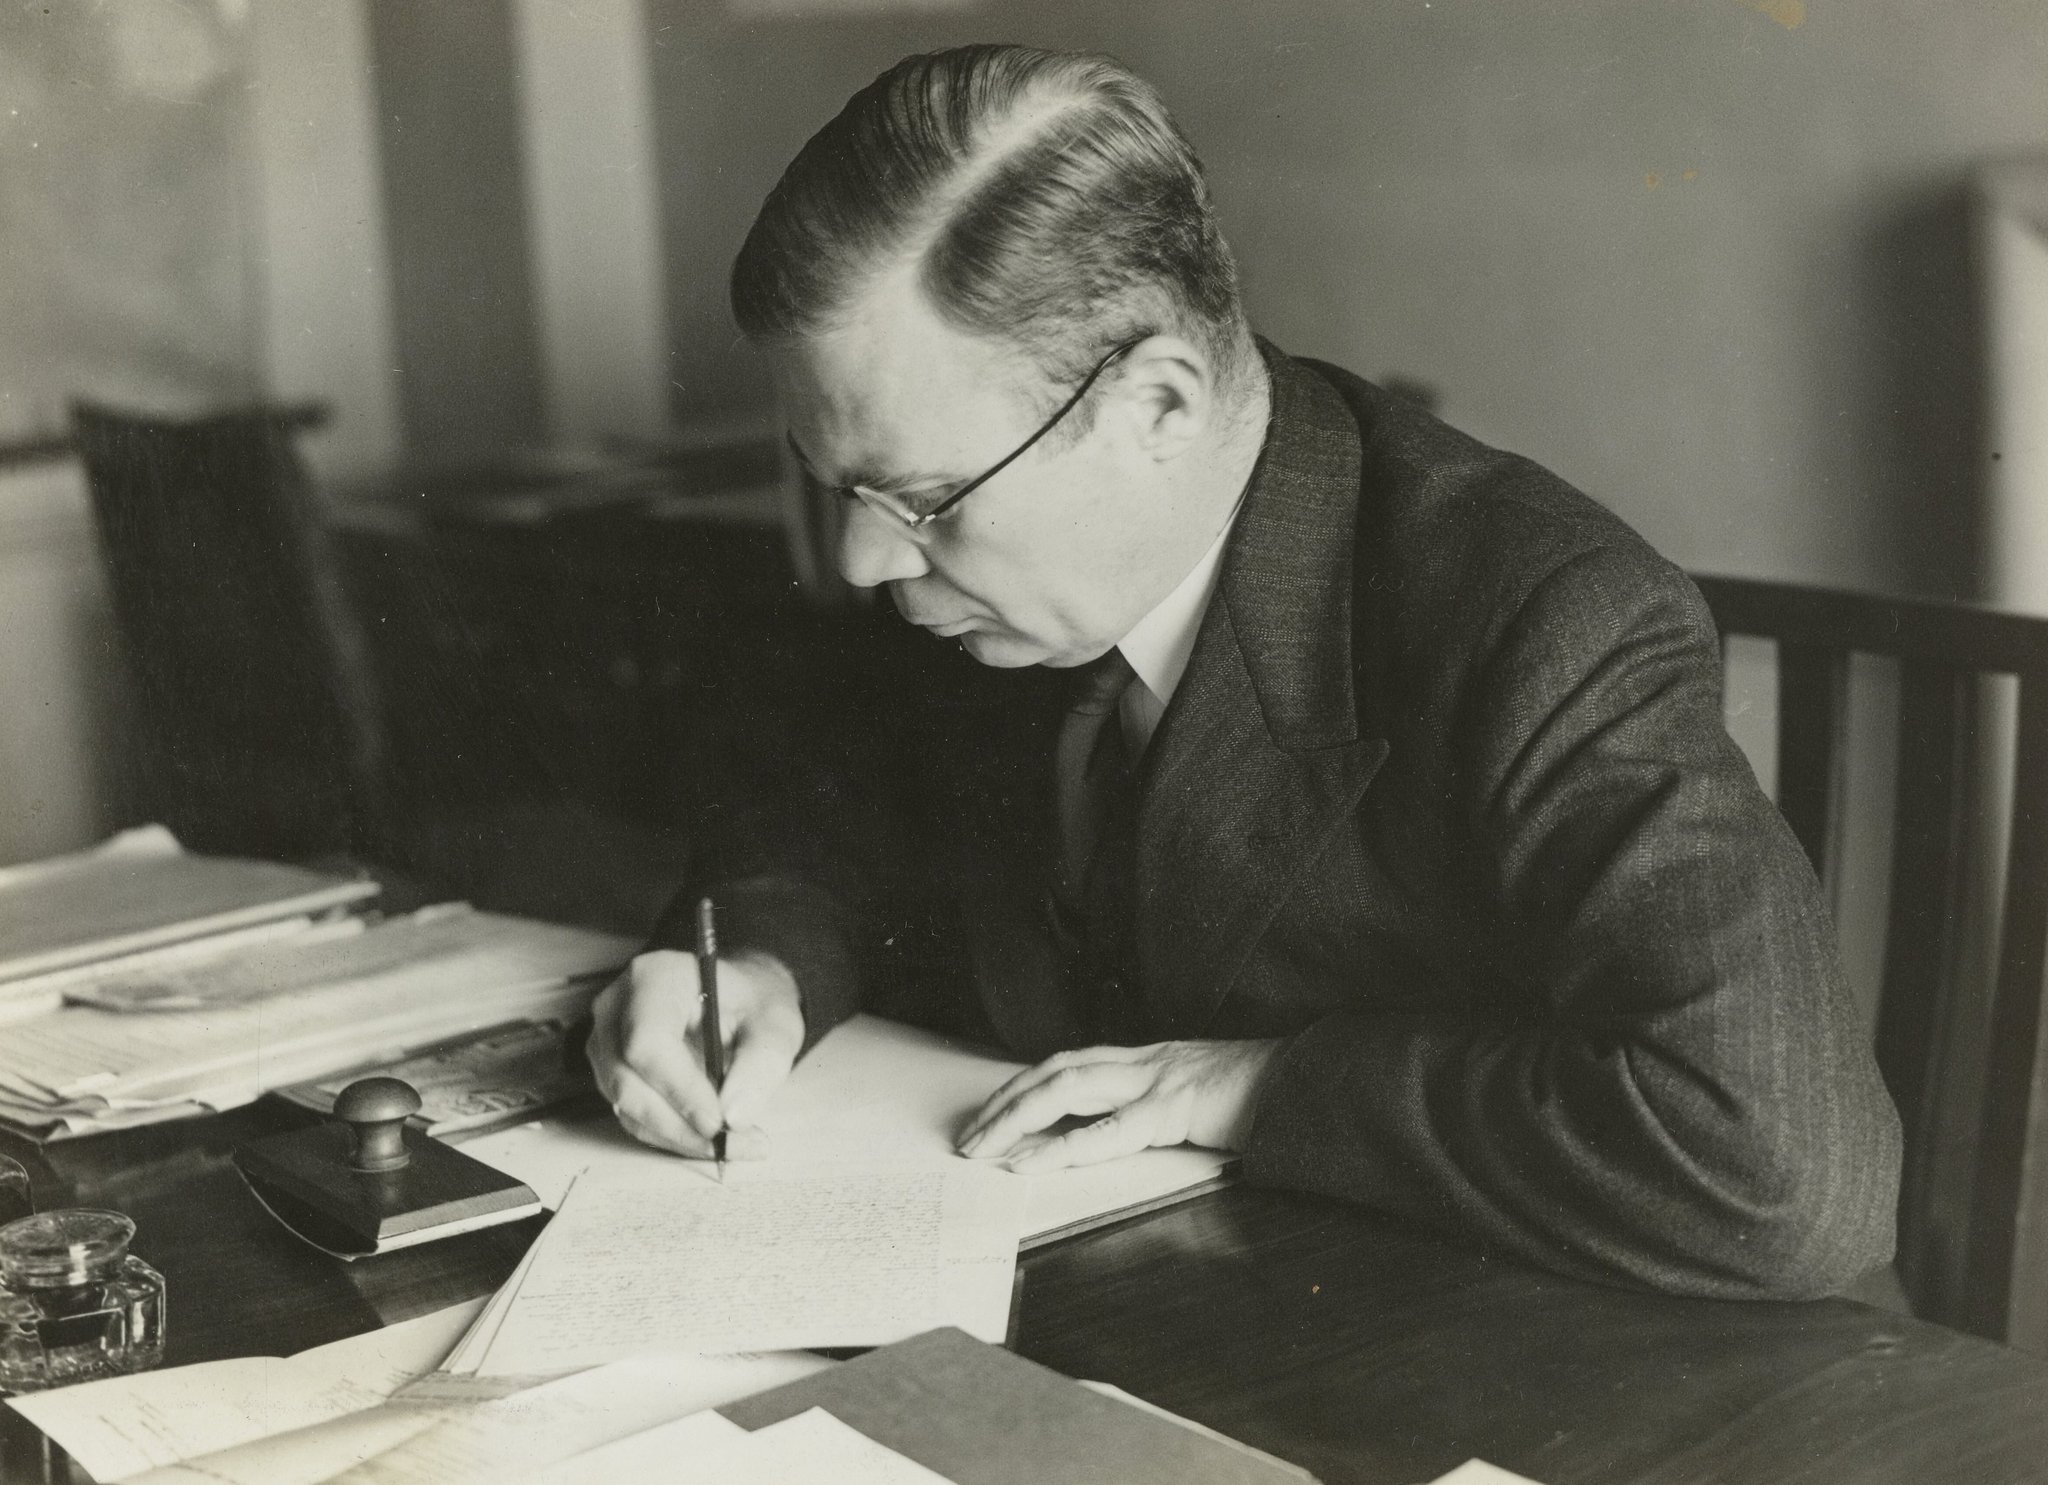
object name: photograph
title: Portret van Hubertus Johannes van Mook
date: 1942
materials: photographic support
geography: london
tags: france, hubertus johannes van mook, london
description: Portret van een werkende minister H.J. van Mook (1894-1965). Hij was tijdens de Tweede Wereldoorlog minister van koloniën in het oorlogskabinet in Londen. Hij behoorde in het interbellum tot de vooruitstrevende krachten in Nederlands-Indië rond het blad 'De Stuw'. Ondanks zijn opvattingen werd hij topambtenaar bij het Indische Gouvernement. Na de inval van Japan week hij uit naar Australië en ging van daar naar Londen. Daar werd hij minister van Koloniën. Na 1945 werd hij de hoogste Nederlandse gezagsdrager in Nederlands-Indië tot hij uit onvrede over de Indië-politiek van de naoorlogse kabinetten verbitterd ontslag nam. Hij werd daarna hoogleraar in de Verenigde Staten. Hij was in de periode 1941-1948: minister, Gouverneur-Generaal van Nederlands-Indië. Deze foto is afkomstig uit de nalatenschap van kunstenaar Cor Visser.